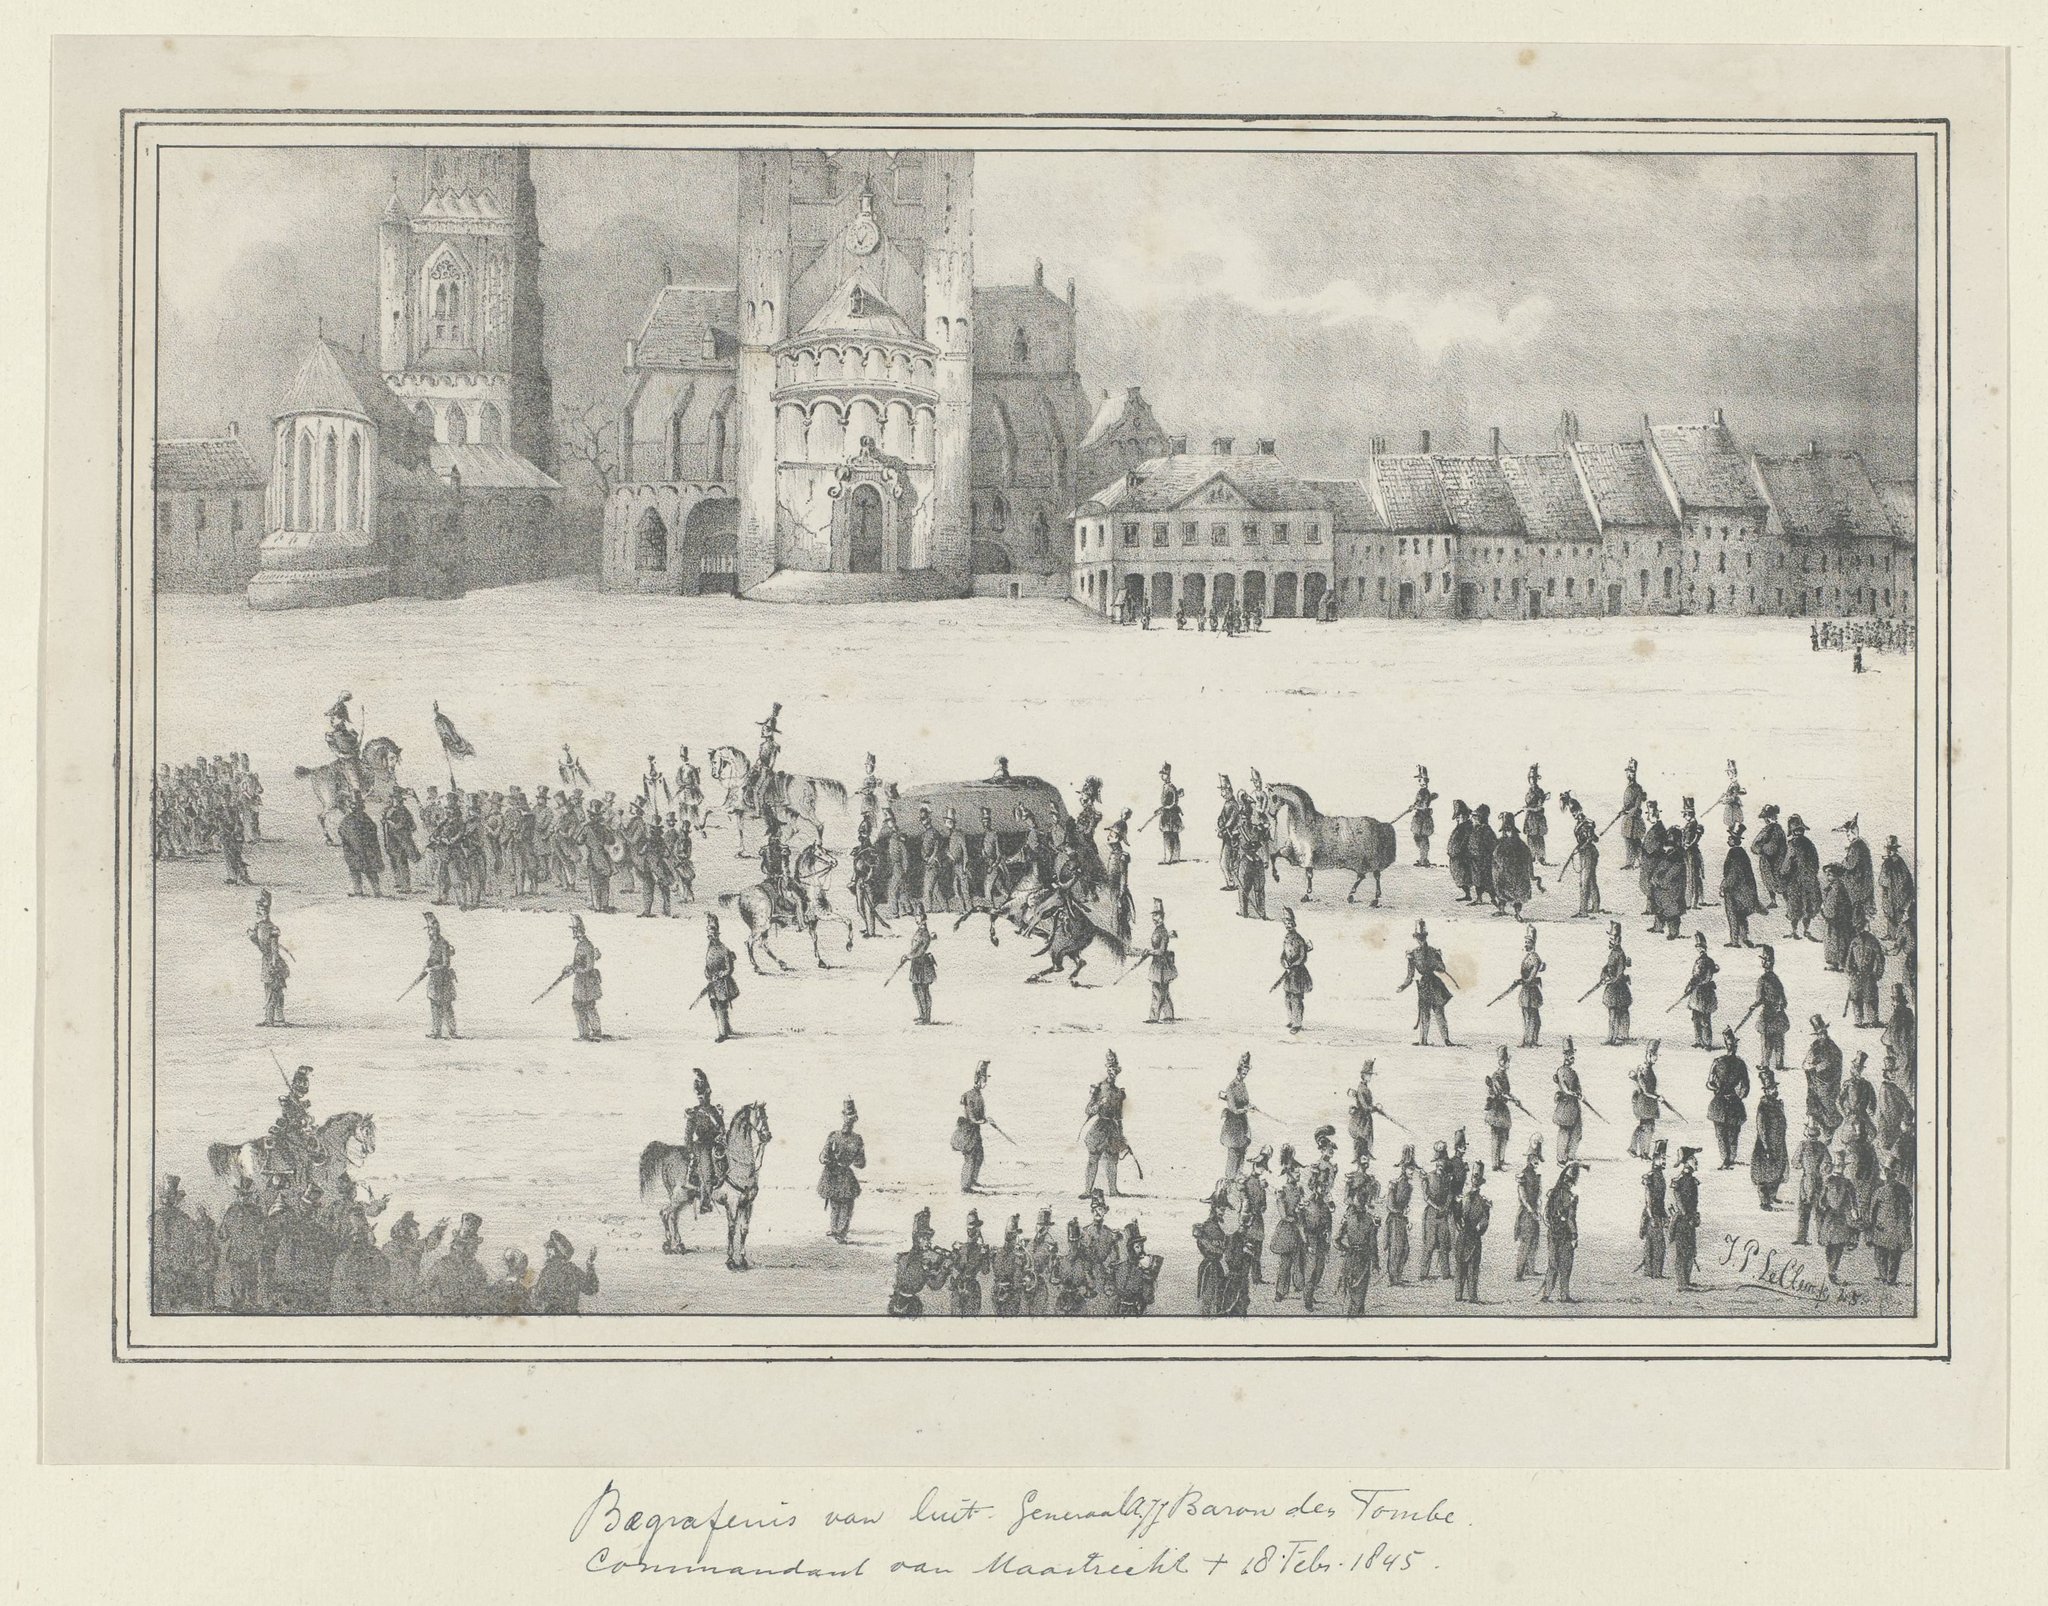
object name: print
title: Begrafenis van A.J.J. Baron des Tombe, 1845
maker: jacques philippe le clerc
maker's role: print maker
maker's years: 1820-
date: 1845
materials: paper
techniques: lithograph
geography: netherlands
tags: cortege, funeral procession, maastricht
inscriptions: collector's mark: Lugt 2760, collector's mark: Lugt 2228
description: Begrafenis van luitenant-generaal A.J.J. Baron des Tombe, commandeur van Maastricht, overleden op 18 februari 1845. De begrafenisstoet trekt over het Vrijthof langs de Sint-Servaasbasiliek.